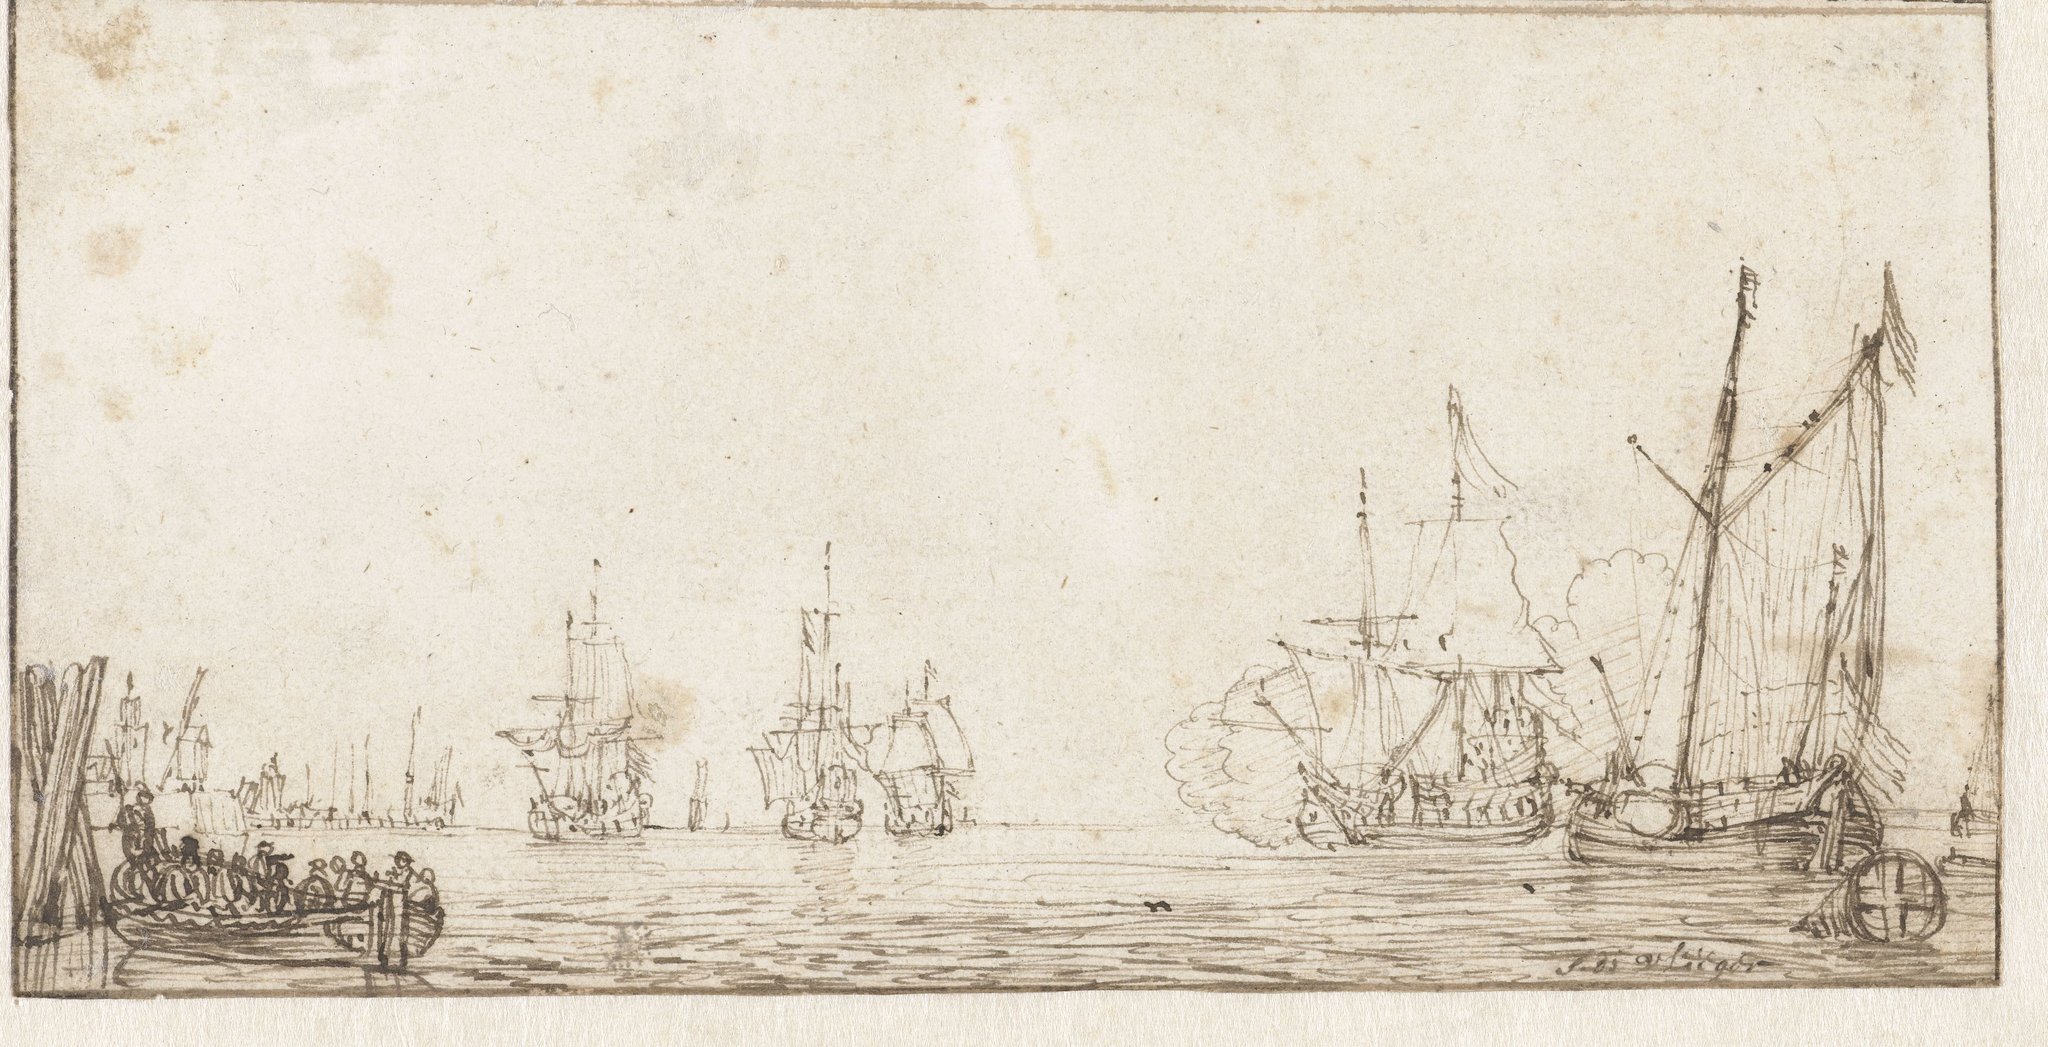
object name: drawing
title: Stille zee met schepen en een roeiboot links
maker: simon de vlieger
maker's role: draughtsman, painter, print maker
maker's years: 1600-1653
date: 1610-1653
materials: ink, paper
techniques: pen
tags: sailing-ship, sailing-boat, ship in the roads, roadstead